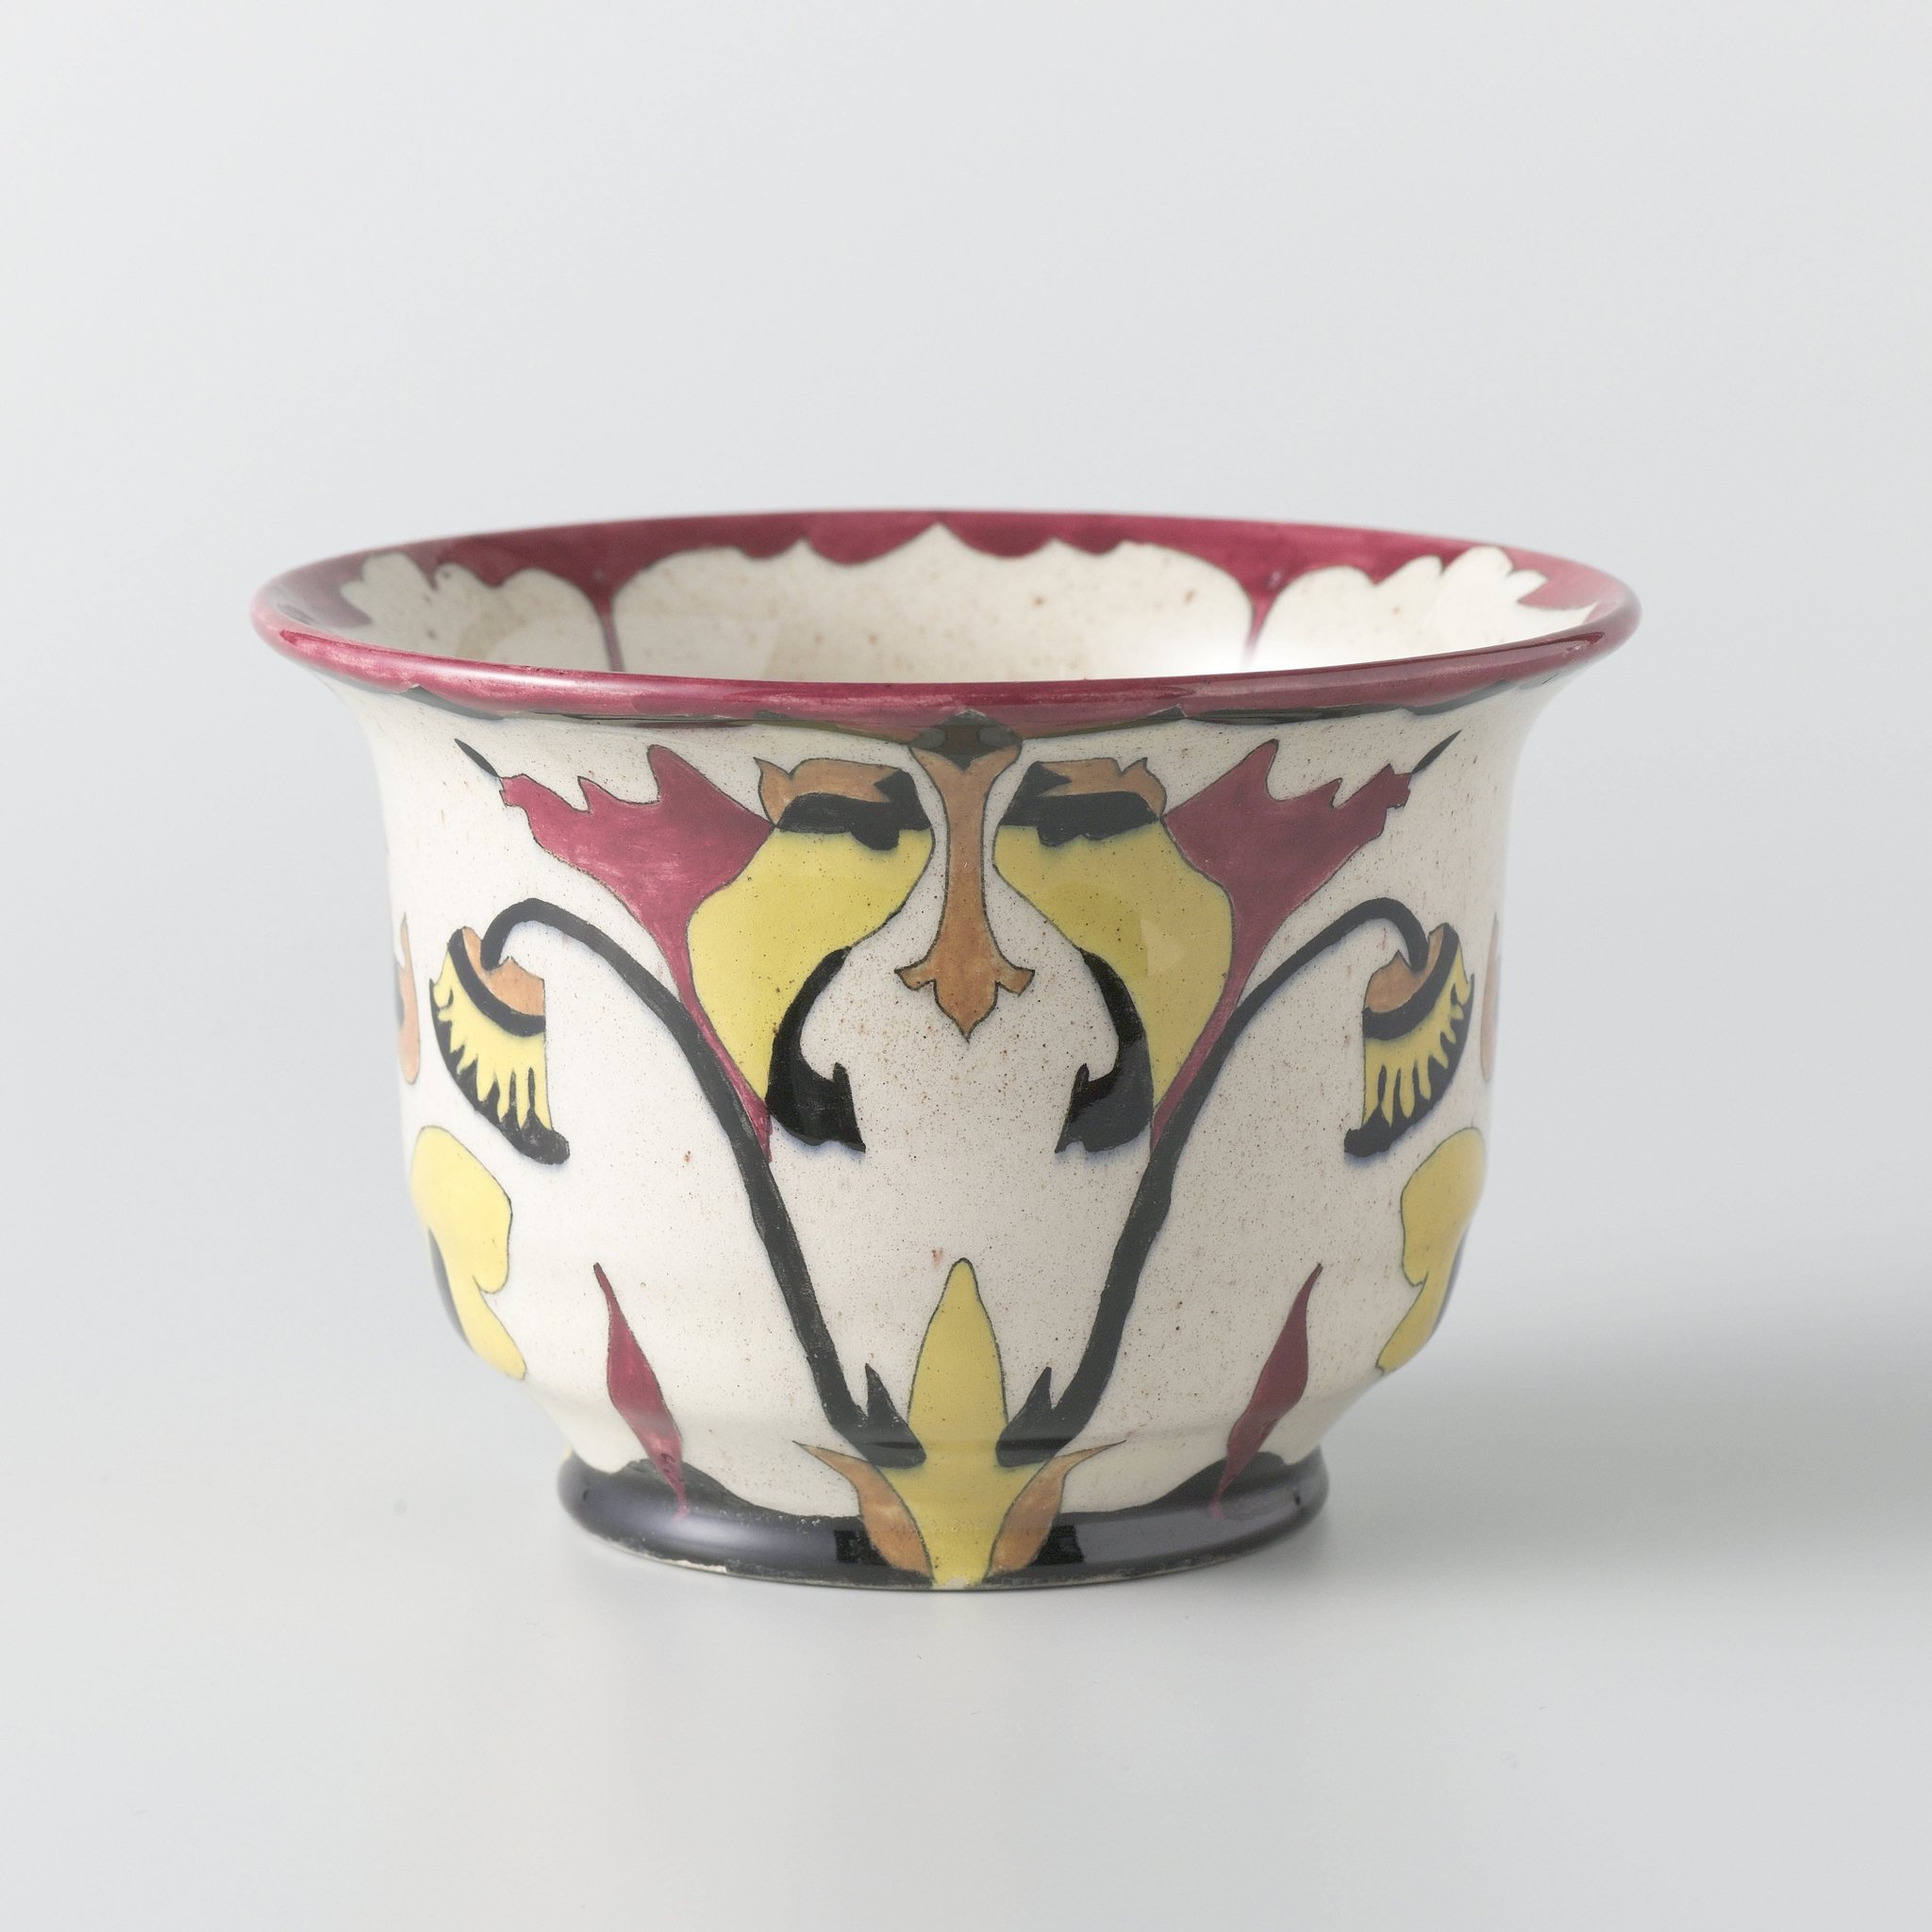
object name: container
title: Bak van aardewerk, versierd met gestileerde bloemmotieven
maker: theo colenbrander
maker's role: draughtsman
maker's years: 1841-1930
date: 1925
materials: earthenware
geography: arnhem